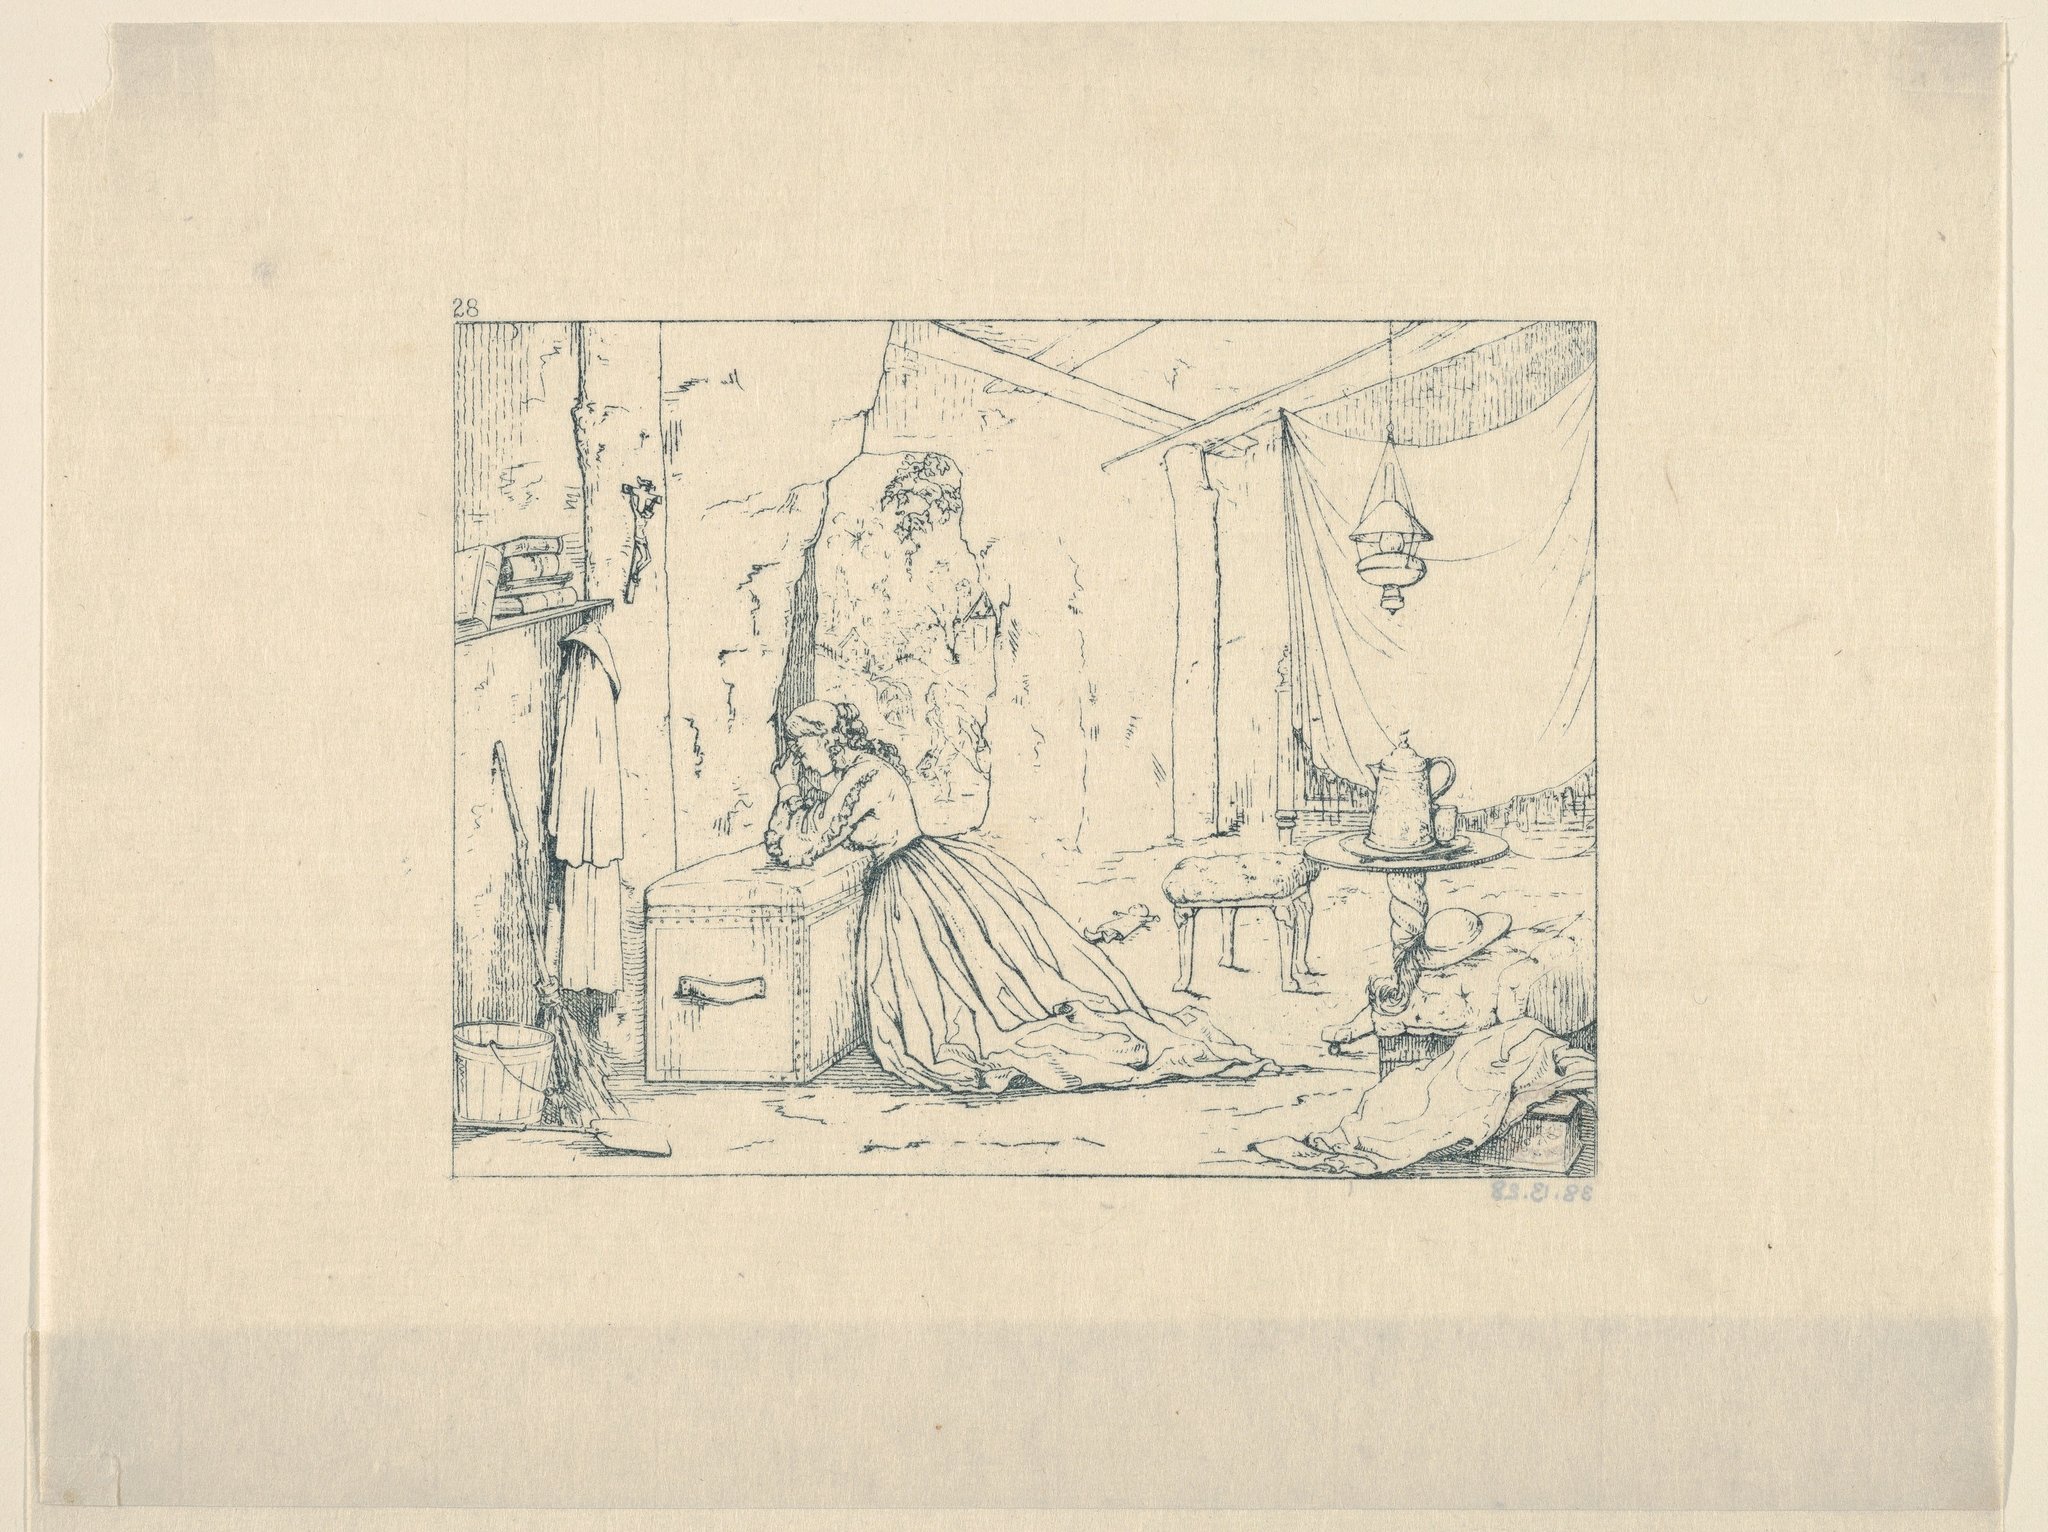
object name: print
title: Cave Life in Vicksburg during the Seige (from Confederate War Etchings)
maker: adalbert john volck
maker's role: artist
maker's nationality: american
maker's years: 1828-1912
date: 1861-1863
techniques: etching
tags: interiors,american civil war,women